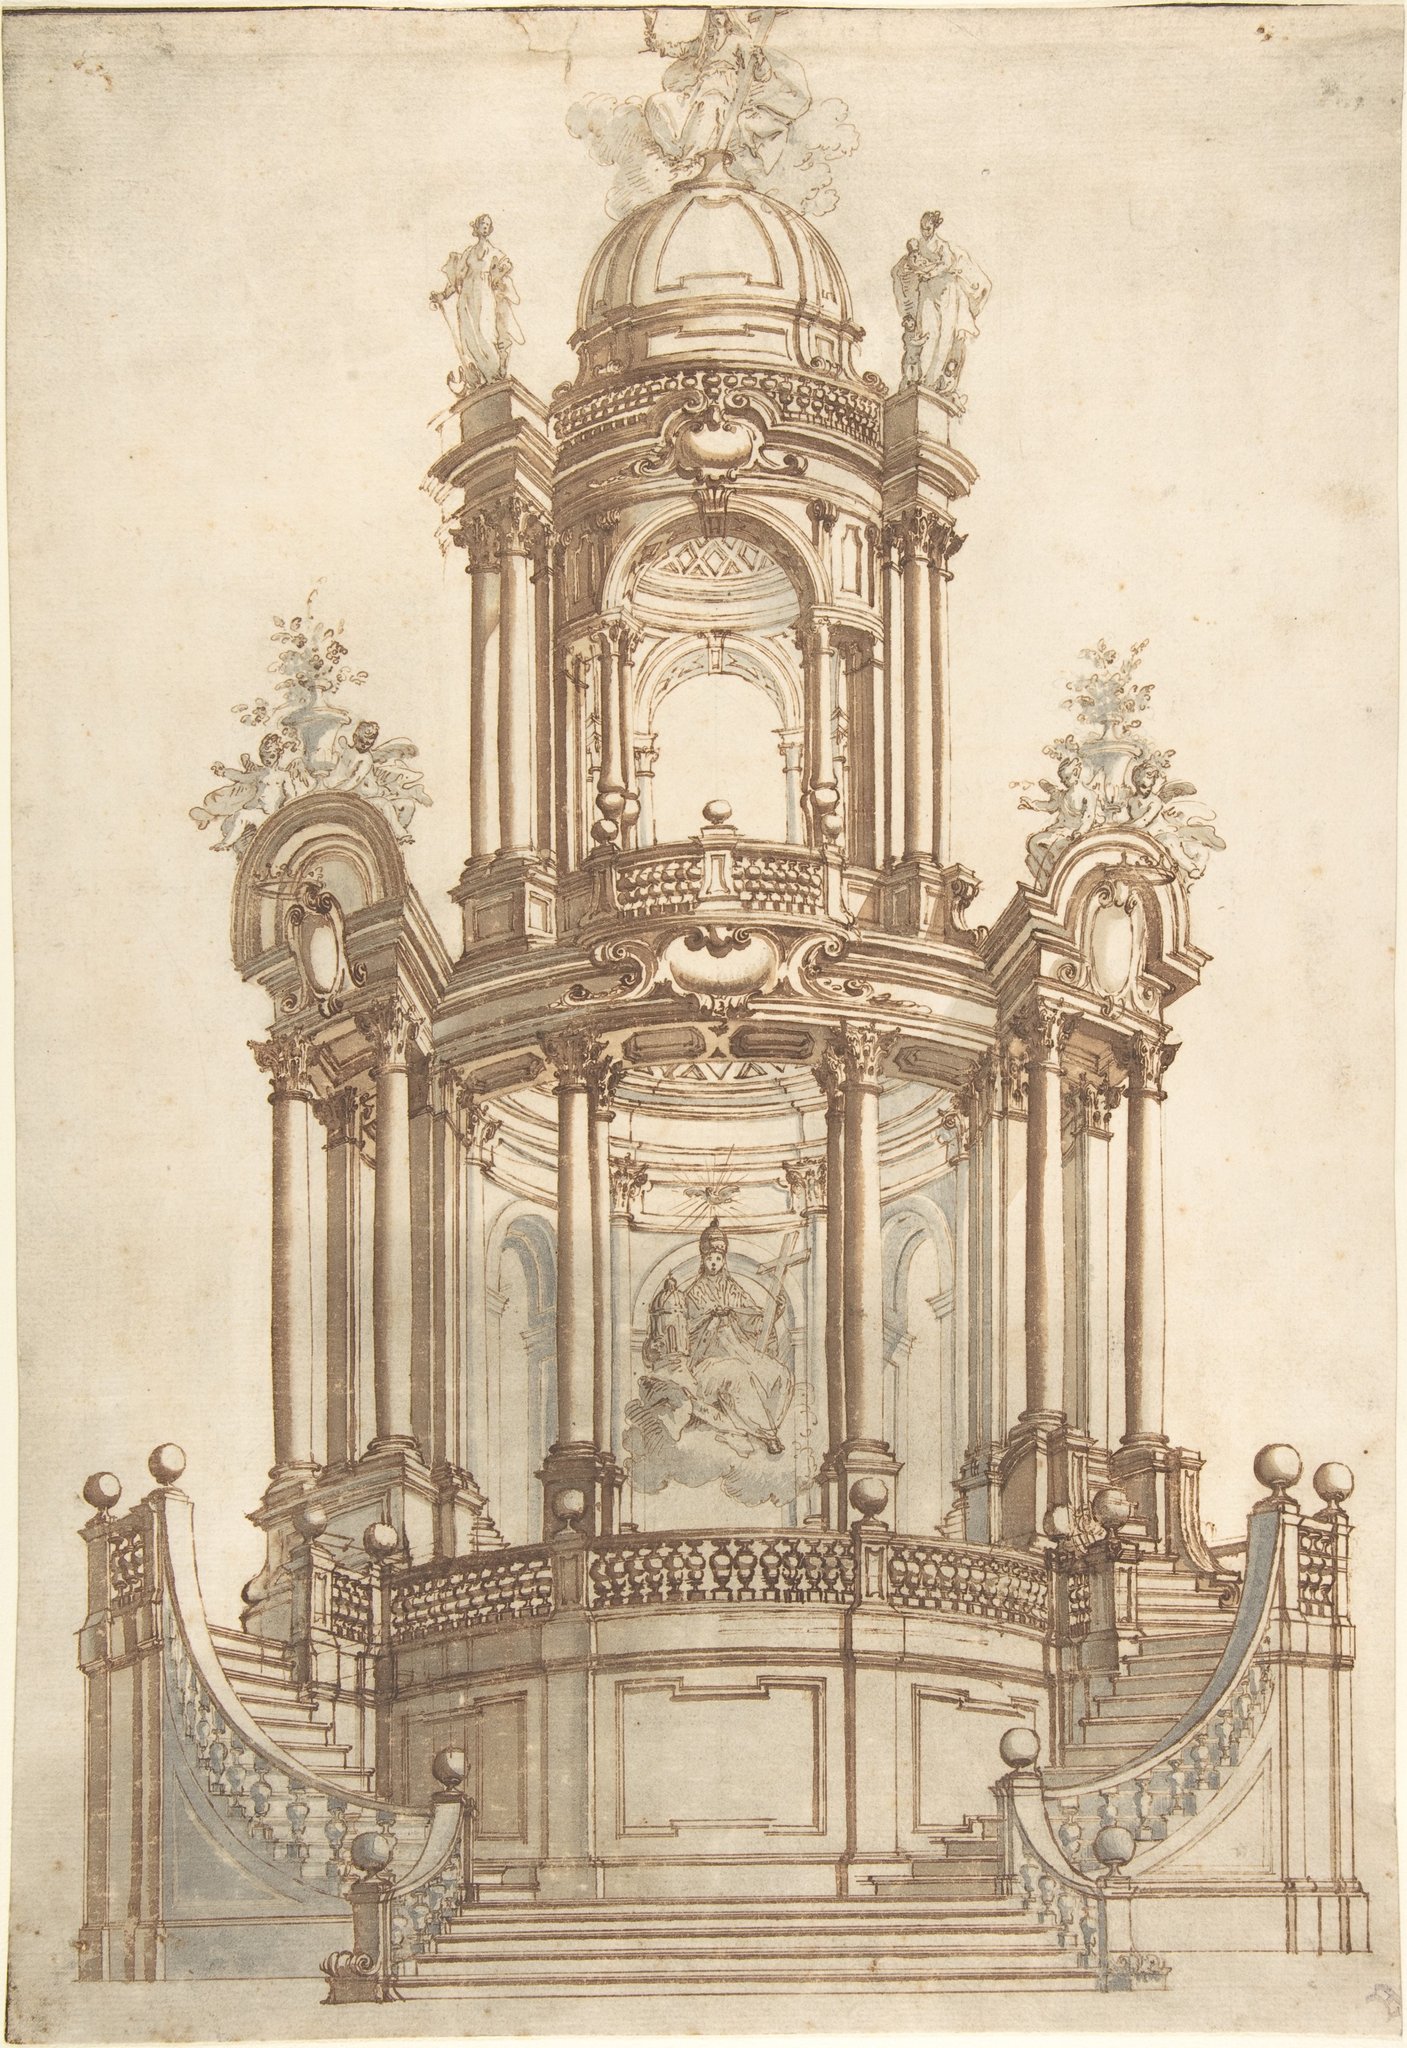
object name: drawing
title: Designs for a Theatrum Sacrum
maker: anonymous, italian, north italy, 18th century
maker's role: artist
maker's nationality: italian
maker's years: 1700-1800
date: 1735-1760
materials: ink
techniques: brush, pen, wash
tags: architecture